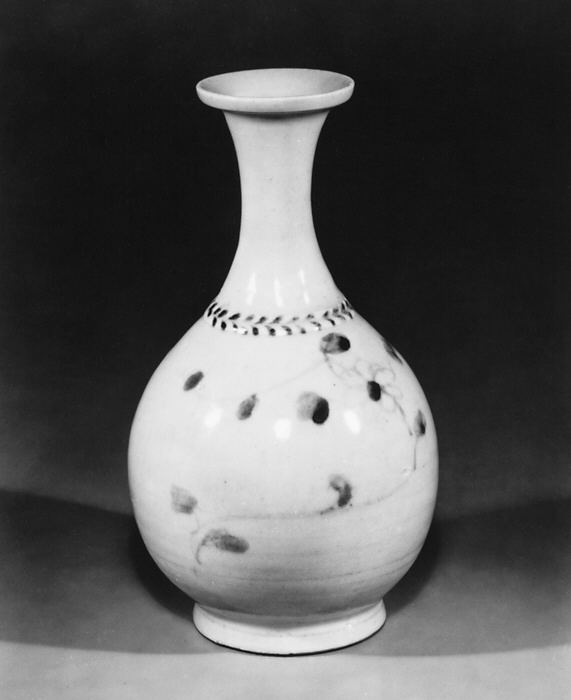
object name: bottle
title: Bottle with Character Design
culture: japanese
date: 1630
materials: porcelain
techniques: underglaze